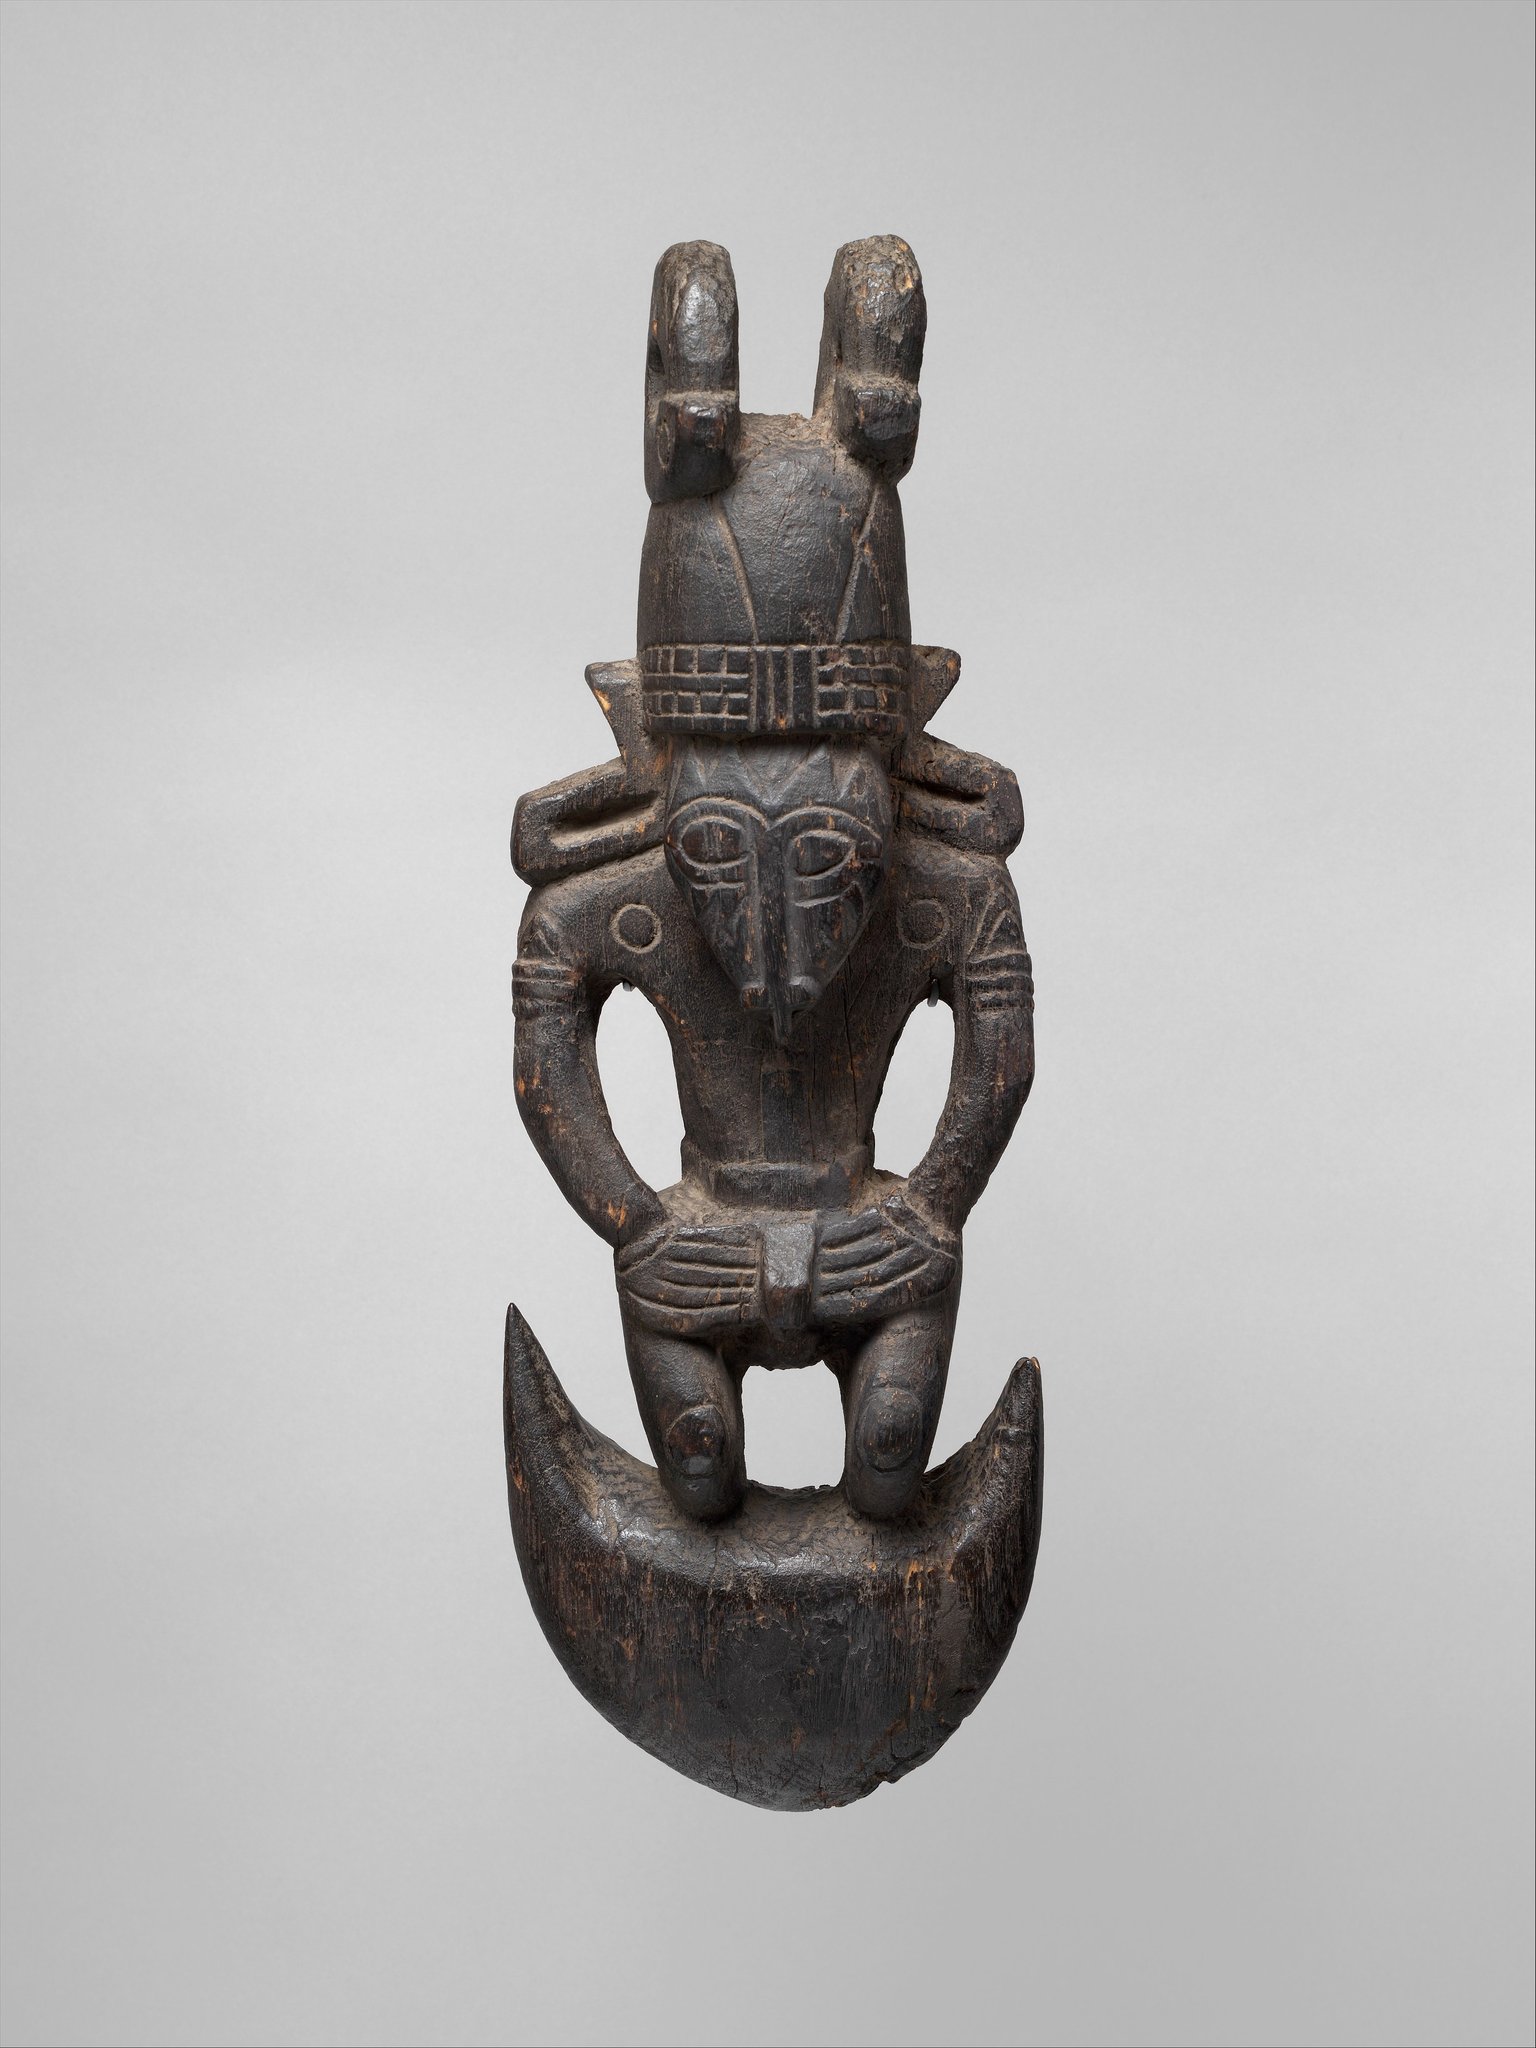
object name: hook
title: Suspension Hook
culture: tami islands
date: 1801-1900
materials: wood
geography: papua new guinea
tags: human figures